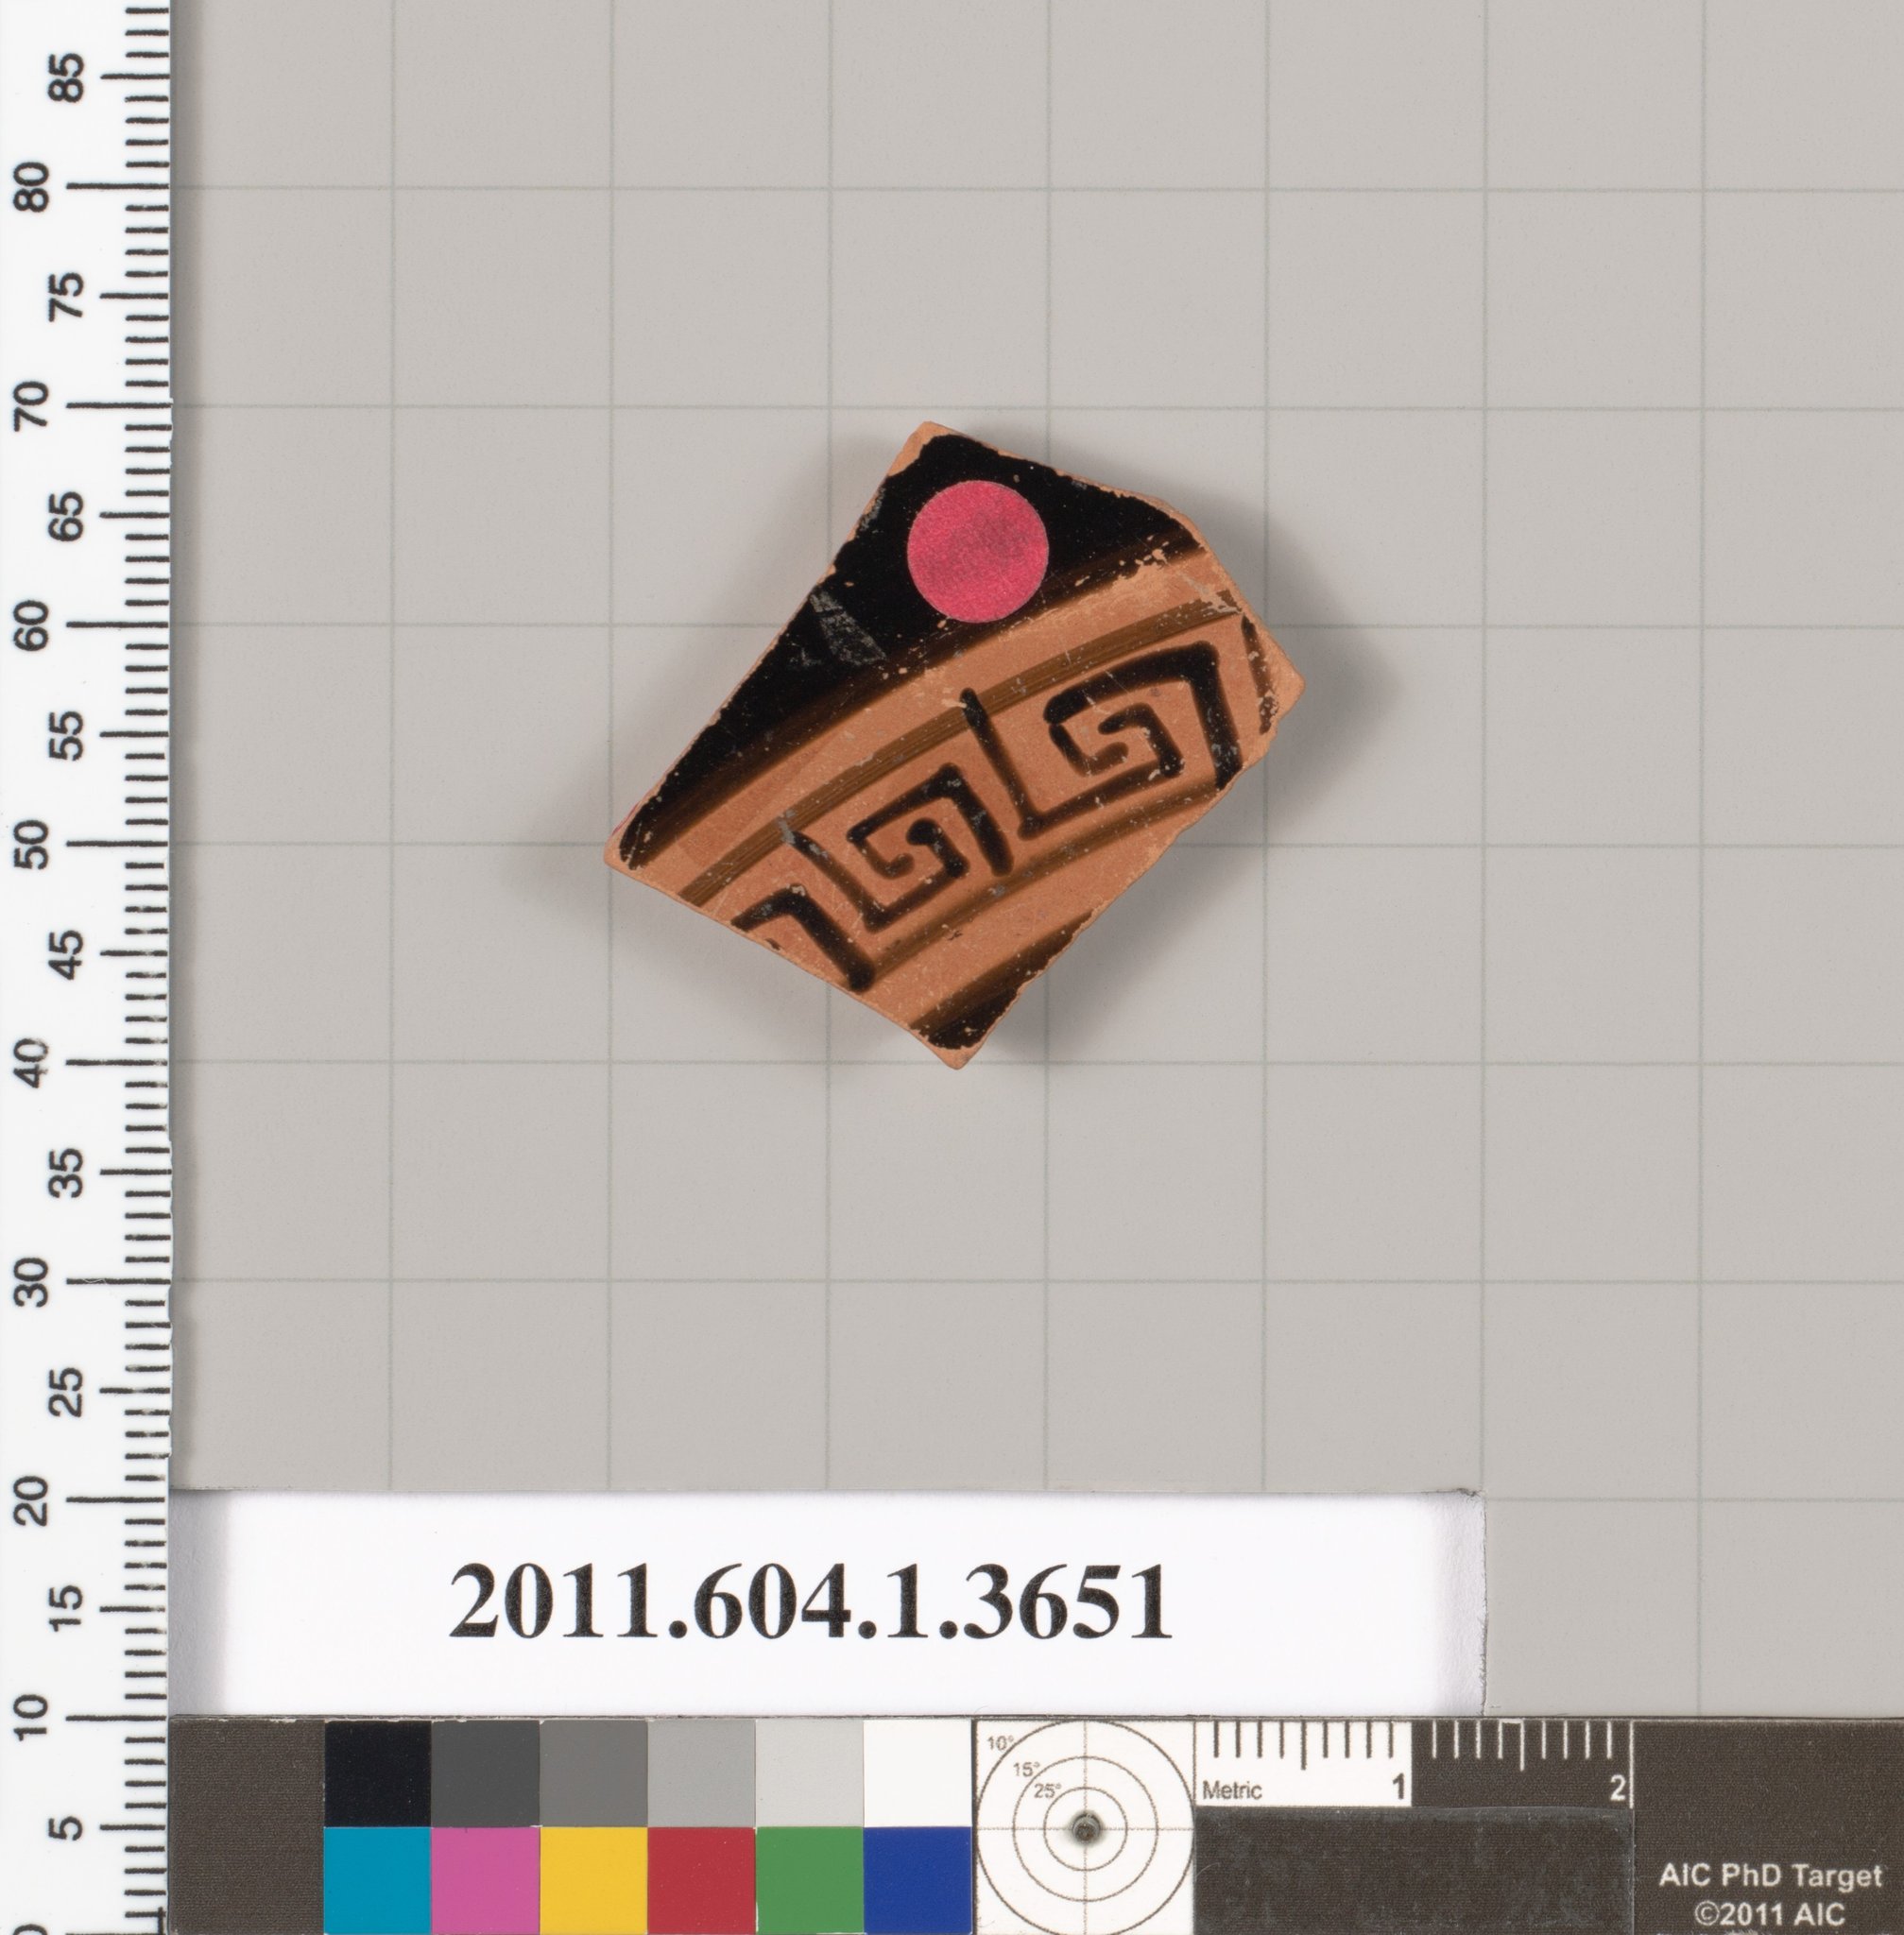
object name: kylix fragment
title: Terracotta fragment of a kylix (drinking cup)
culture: greek, attic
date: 500-470 BCE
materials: terracotta